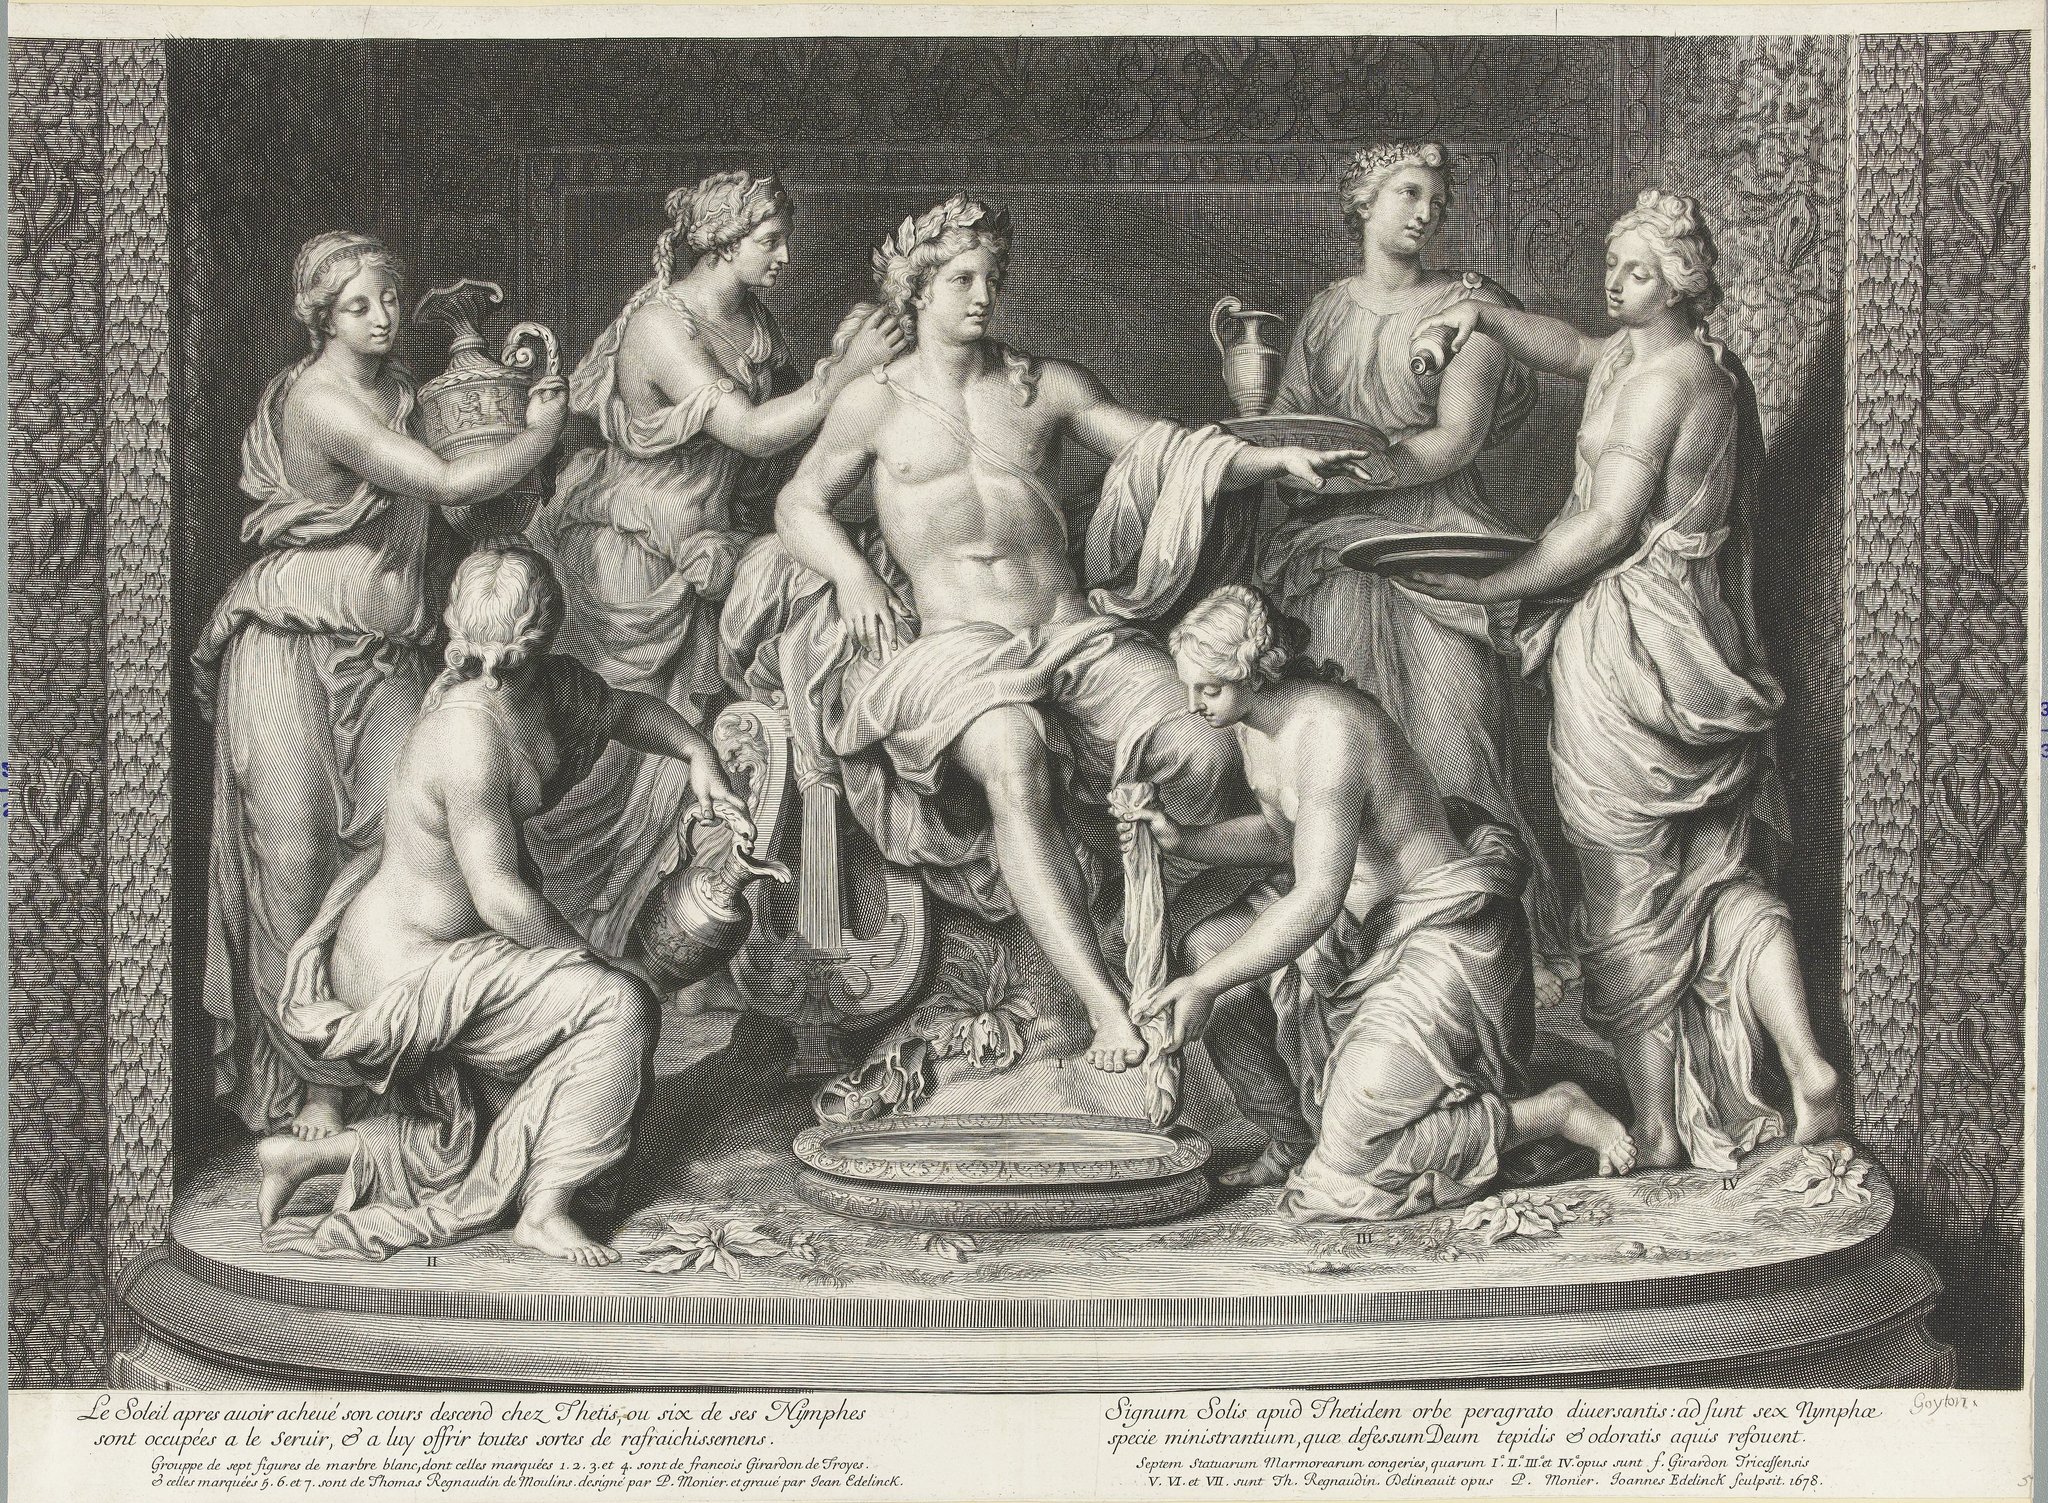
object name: print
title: Apollo en zes muzen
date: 1678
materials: paper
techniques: engraving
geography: paris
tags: (story of) apollo (phoebus)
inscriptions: collector's mark: Lugt 240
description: Apollo met laurierkrans en zijn lier naast hem op de grond, wordt verzorgd door zes muzen. Onder de voorstelling vier regels in het Frans en vier in Latijn, waarin onder meer wordt verwezen naar de verschillende beeldhouwers.